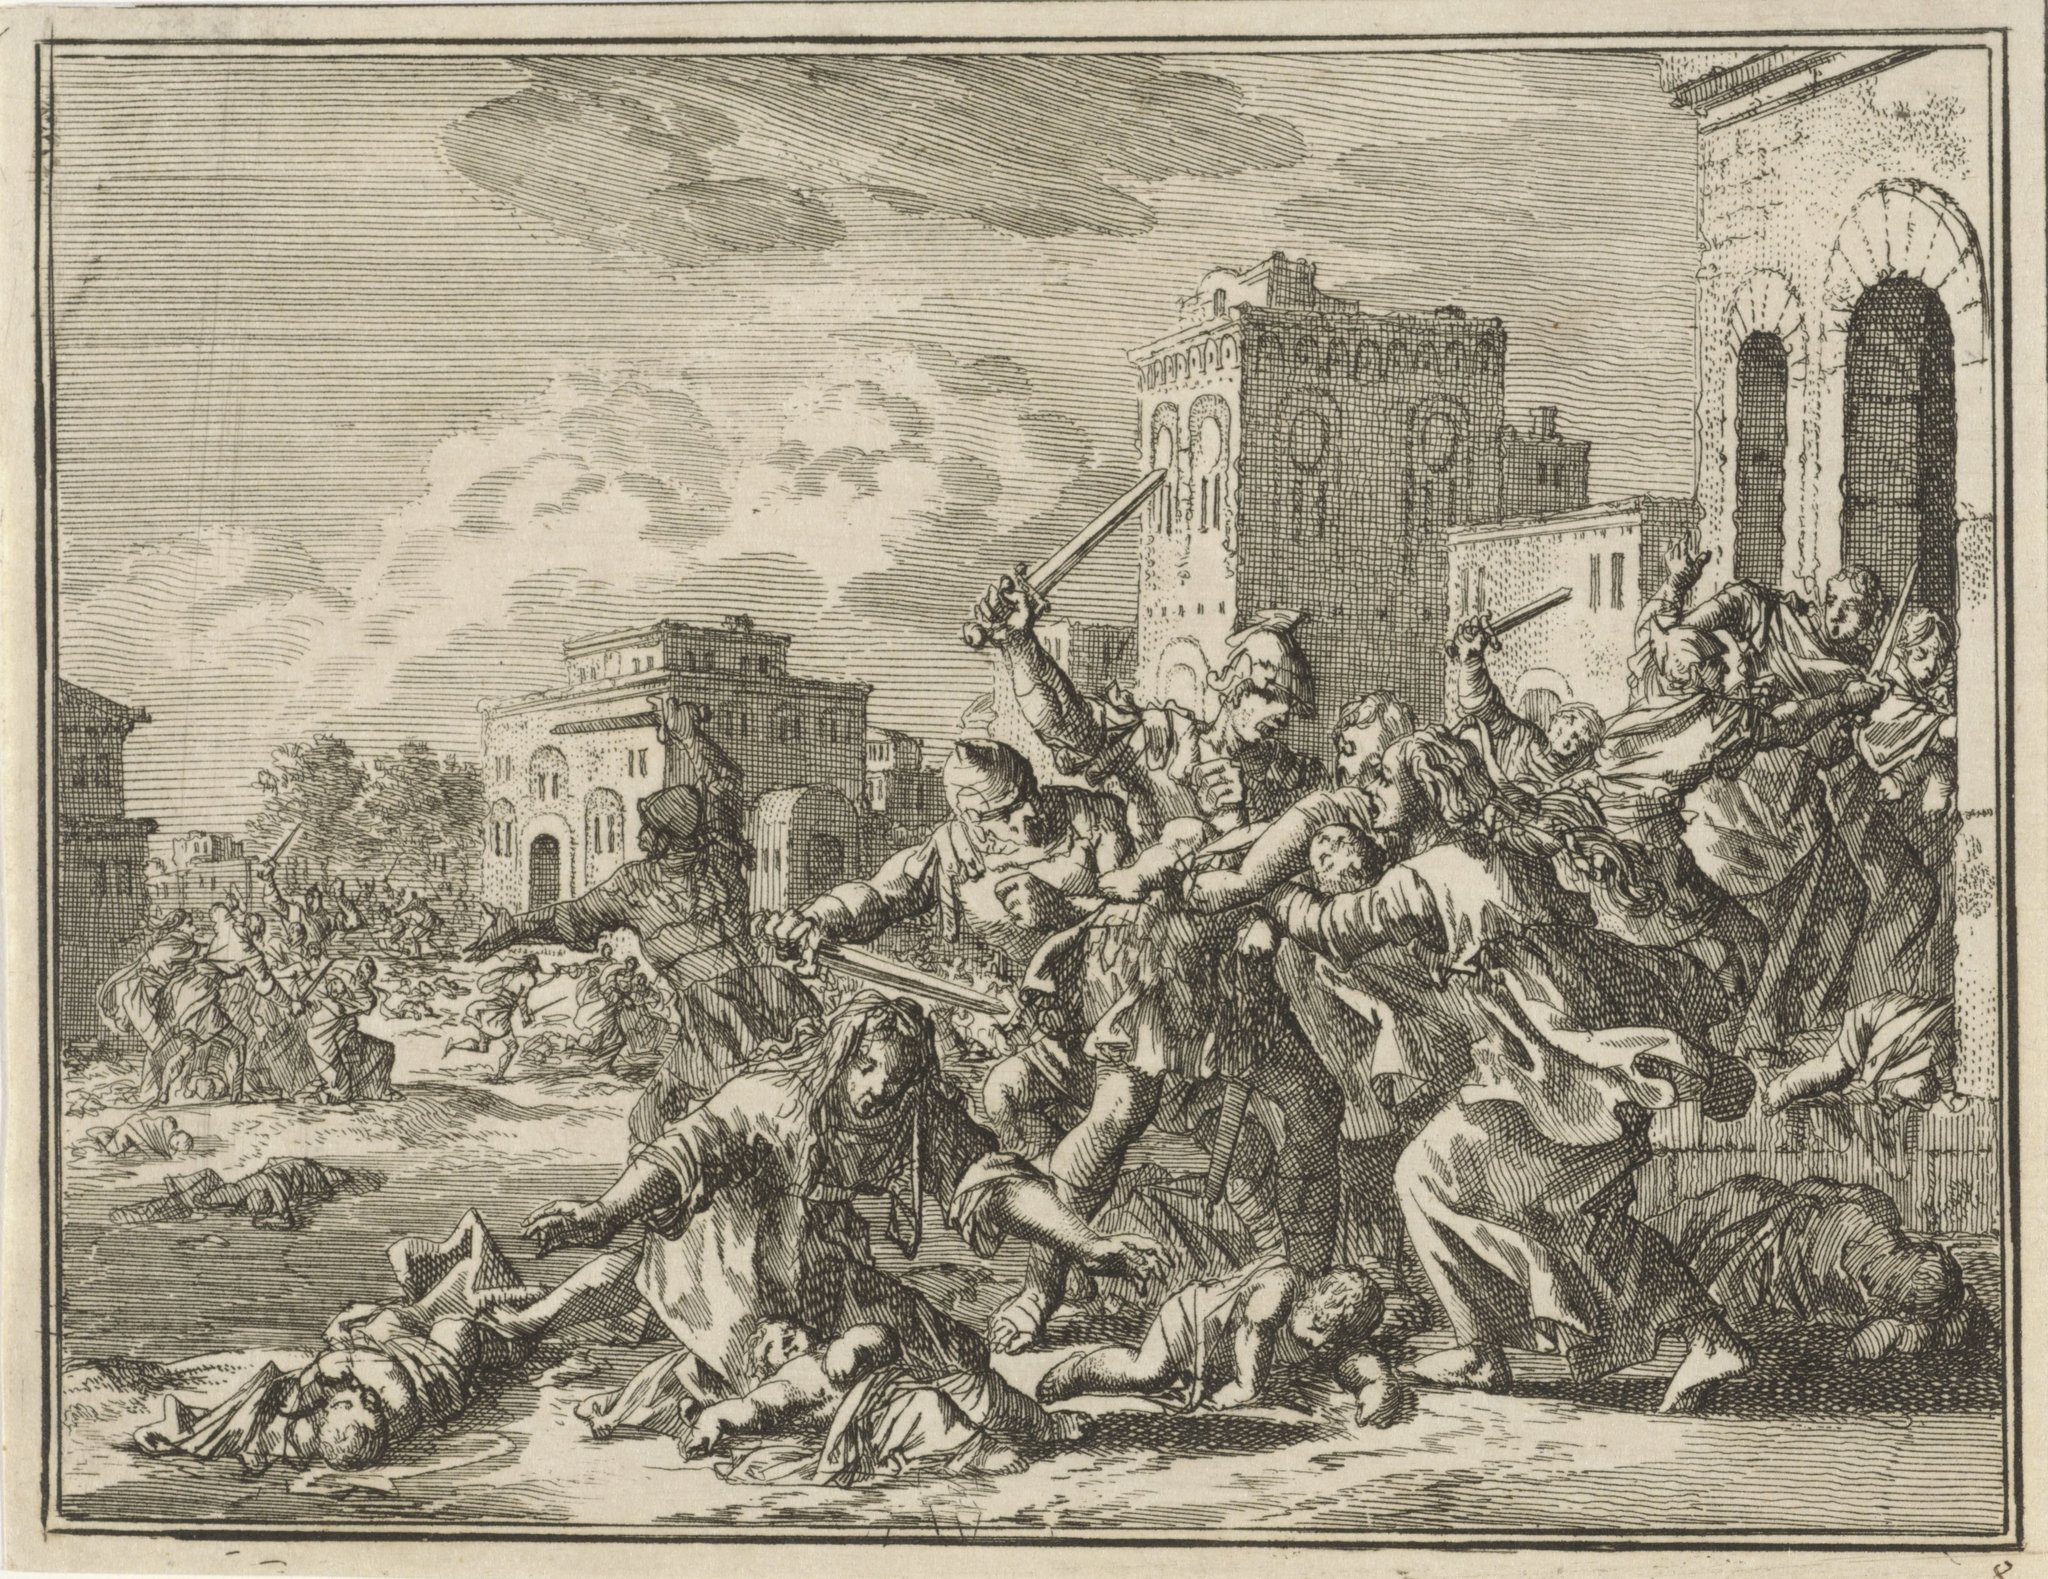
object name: print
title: Kindermoord te Bethlehem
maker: jan luyken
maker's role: draughtsman, print maker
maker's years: 1649-1712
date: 1712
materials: paper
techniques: etching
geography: amsterdam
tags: the massacre of the innocents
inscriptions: number: ‘8’, collector's mark: Lugt 2228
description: Proefdruk van illustratie uit: Luyken, Jan. De schriftuurlyke geschiedenissen en gelykenissen van het Oude en Nieuwe Verbond, 2 delen. Amsterdam: Wed. Pieter Arentsz II en Cornelis van der Sys, 1712, dl. II.